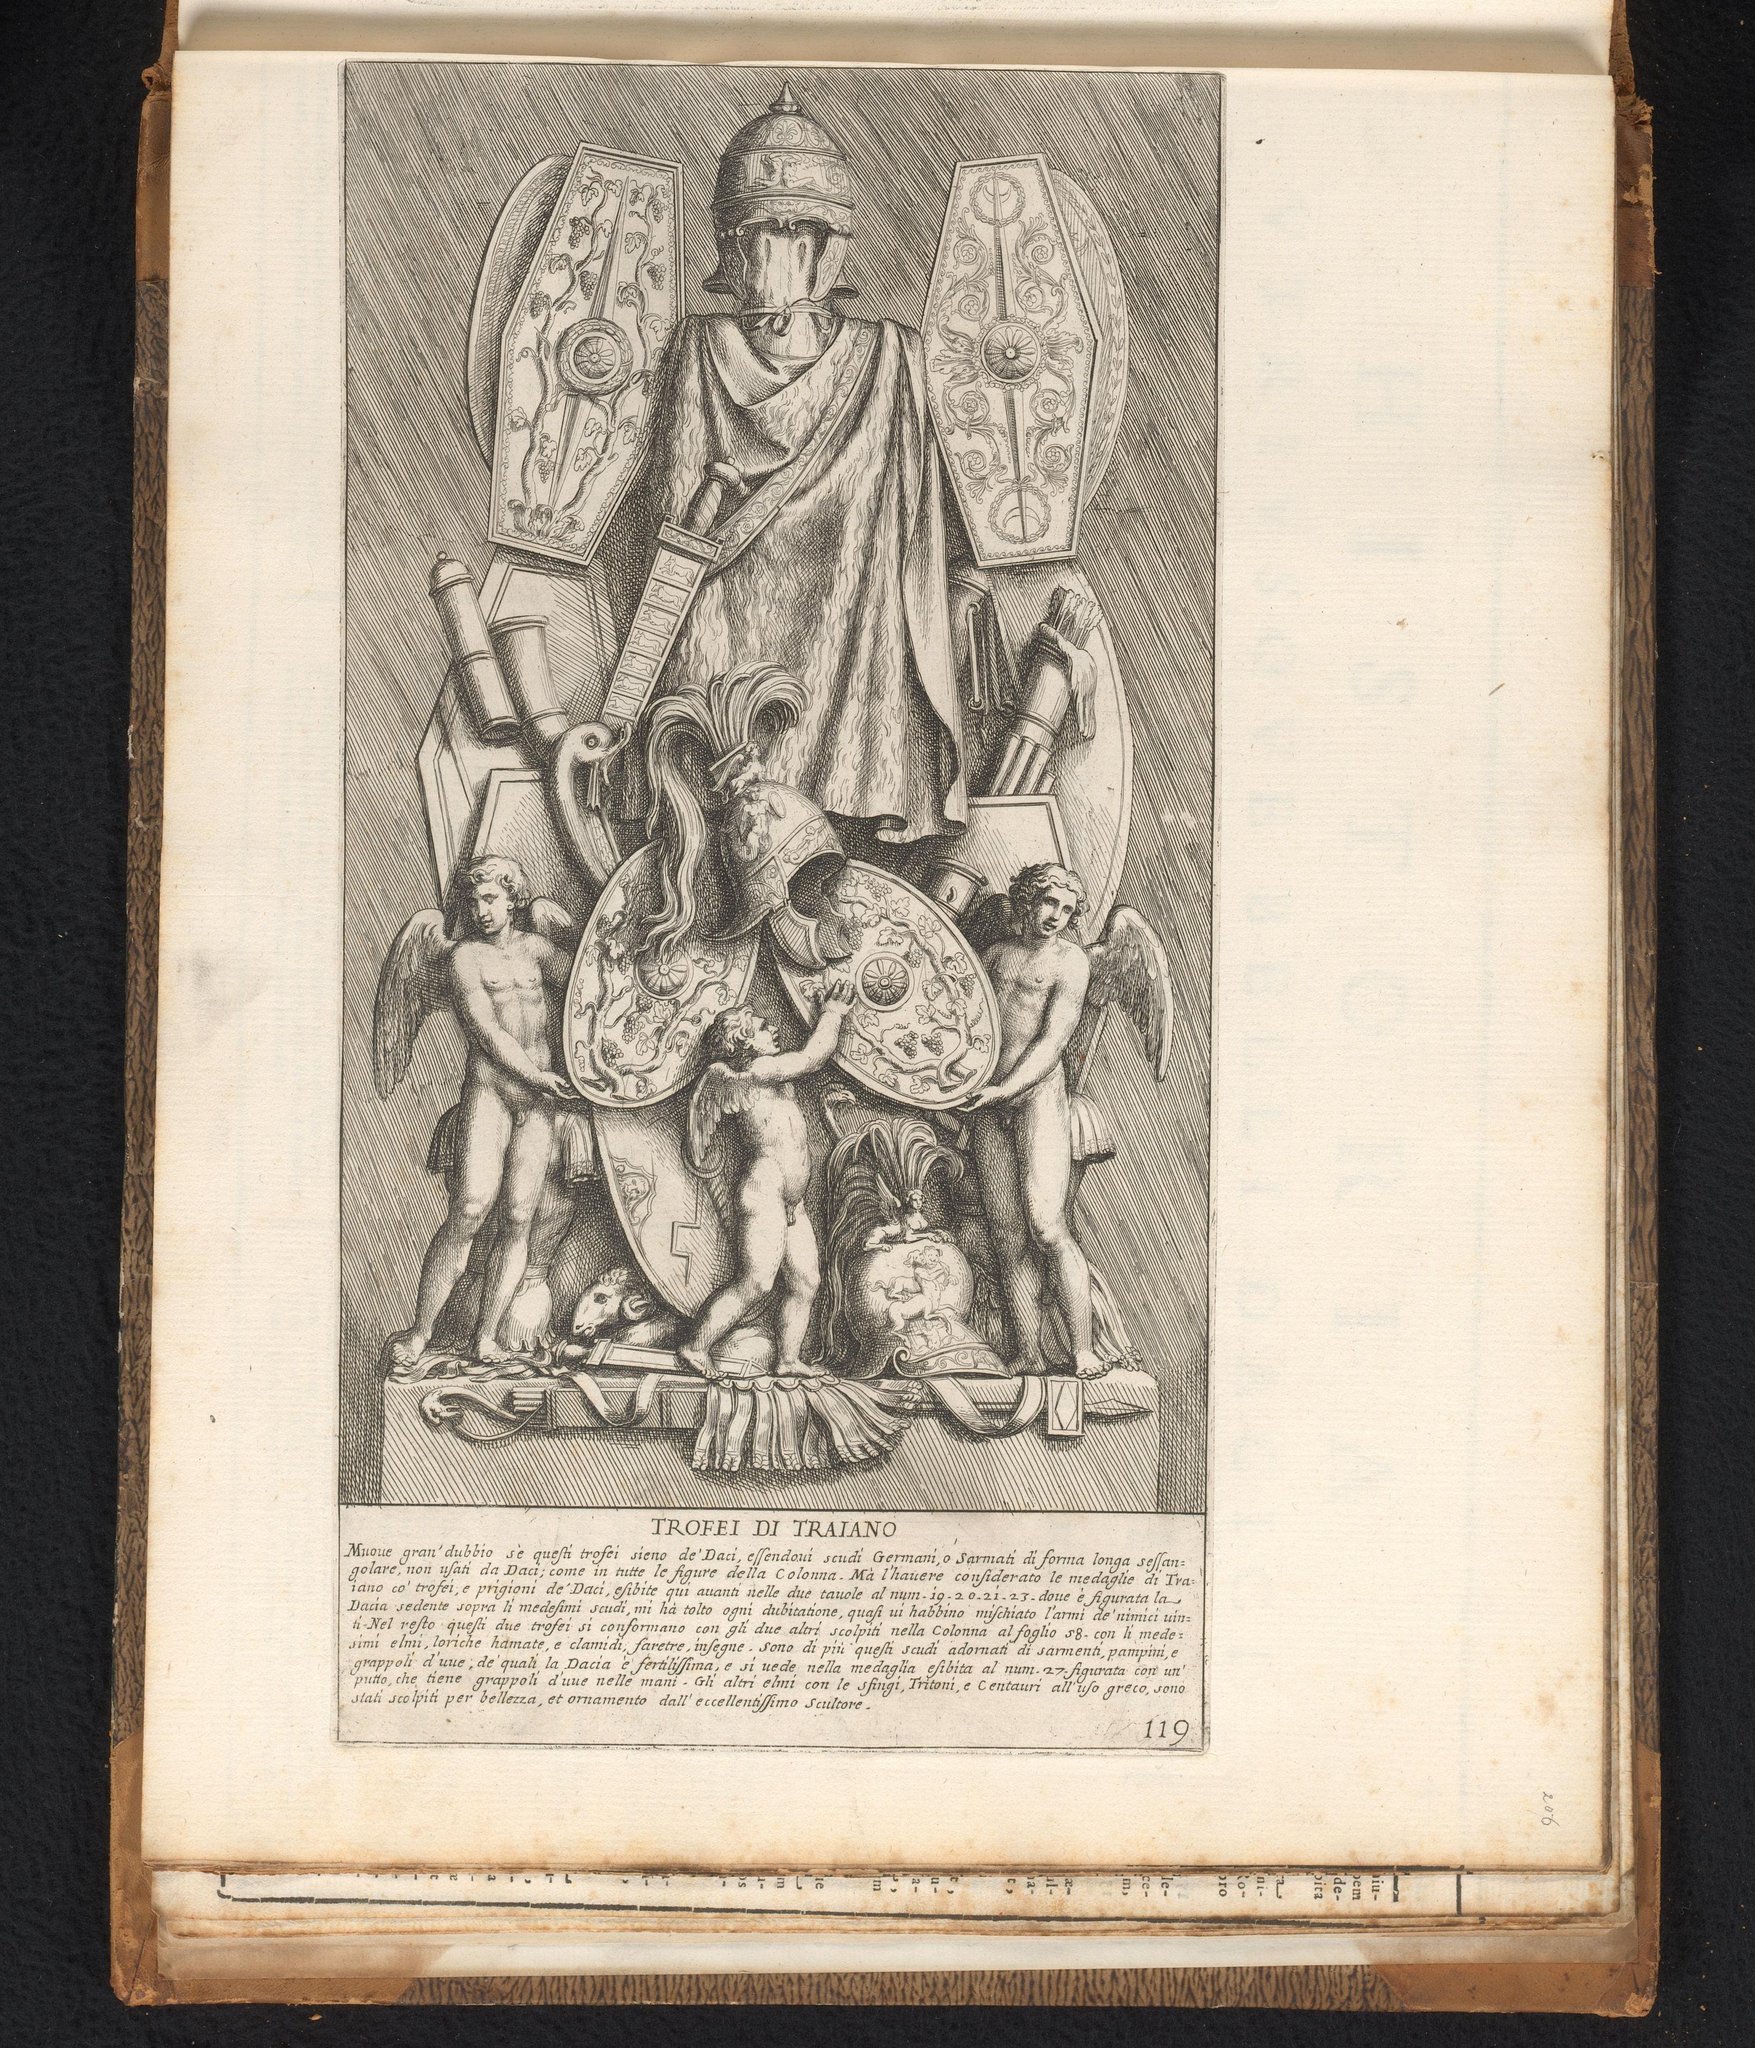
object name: album leaf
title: Oorlogstrofeeën van keizer Trajanus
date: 1637-1691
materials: paper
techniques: etching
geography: rome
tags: trophy ~ battle, war, cupids: 'amores', 'amoretti', 'putti', angels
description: Deze prent maakt deel uit van een reeks van 128 prenten(+ titelprent) (alleen de 119 prenten met details van het grote fries zijn genummerd) met voorstellingen van de Zuil van Trajanus.